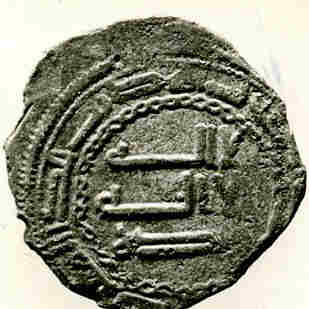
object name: coin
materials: copper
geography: iran